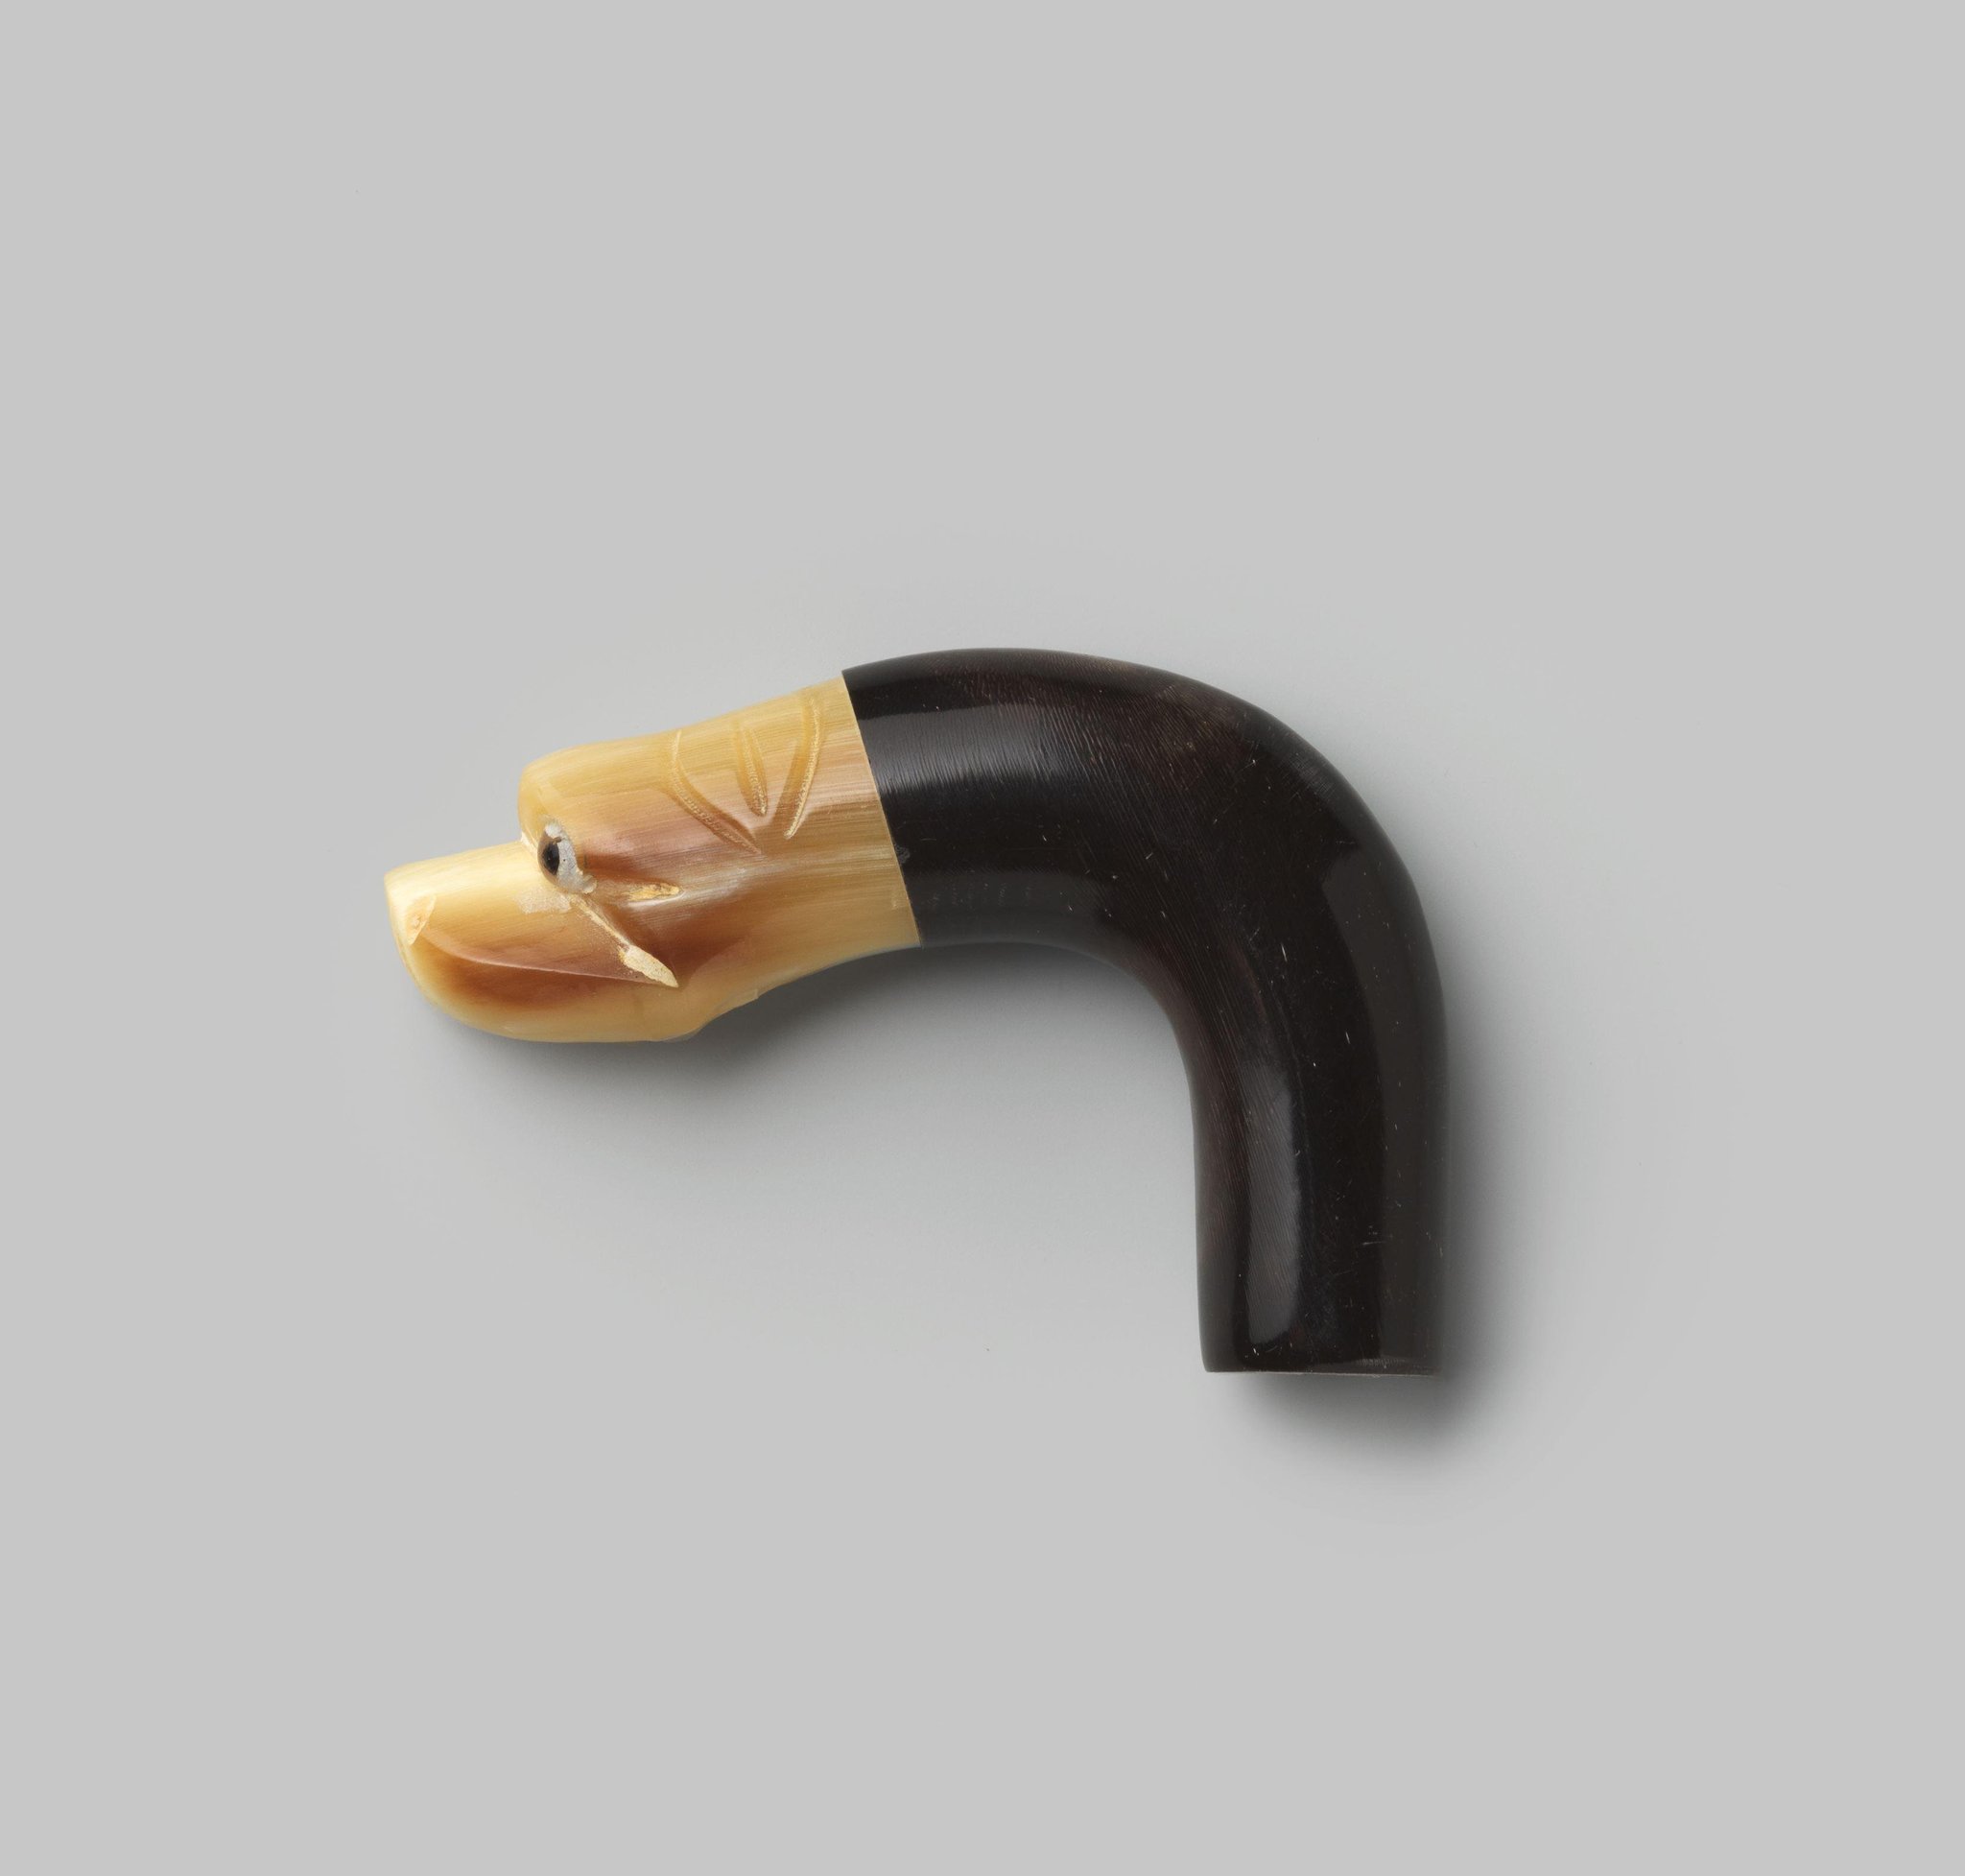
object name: haakknop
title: Knop van zwart hoorn, eindigend in een hondenkop van beige hoorn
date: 1900-1930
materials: glass, horn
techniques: manufacturing, cutting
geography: netherlands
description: Knop van zwart hoorn, eindigend in een hondenkop van beige hoorn, ogen van glas.